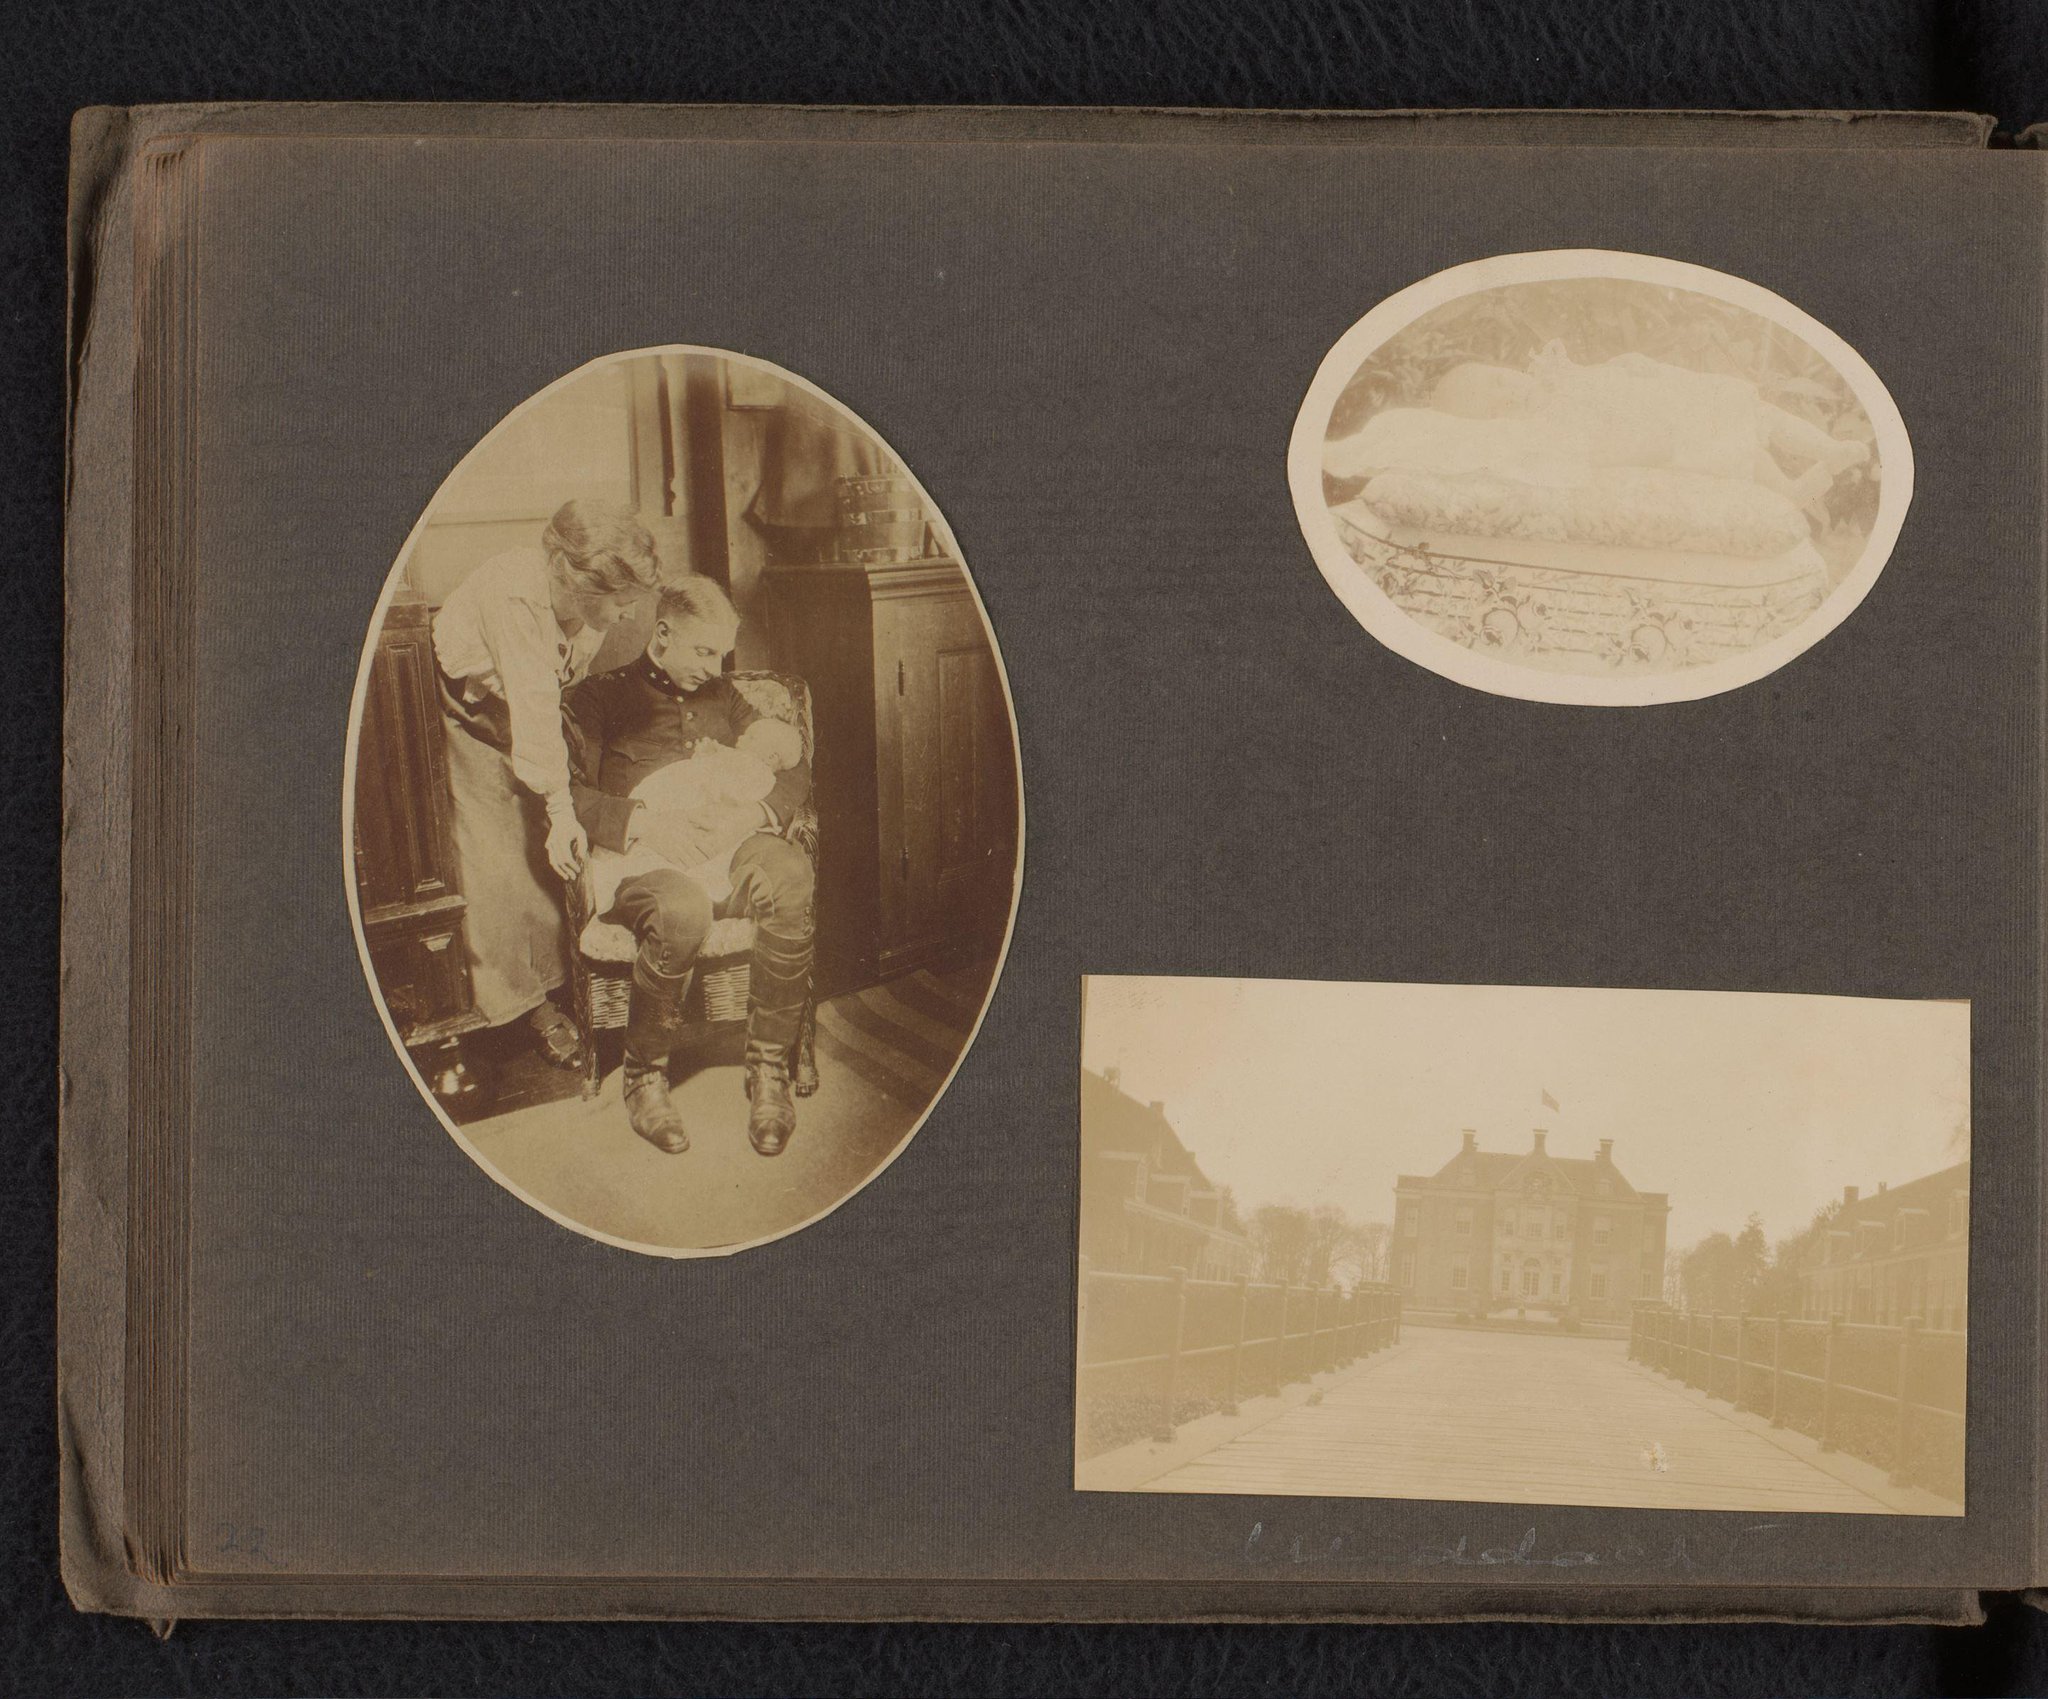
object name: album leaf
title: Drie foto's van ouders met een kind, mogelijk Pieter Dudok van Heel, en een gezicht op kasteel Middachten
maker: Anonymous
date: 1919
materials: paper, cardboard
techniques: gelatin silver print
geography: de steeg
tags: emilie albertina onnen (milly), castle, family group, especially parents with their child(ren), historical persons, infant, baby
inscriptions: caption: ‘wandeltocht./ Arnhem-Deventer’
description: Deze foto's maken deel uit van een album.